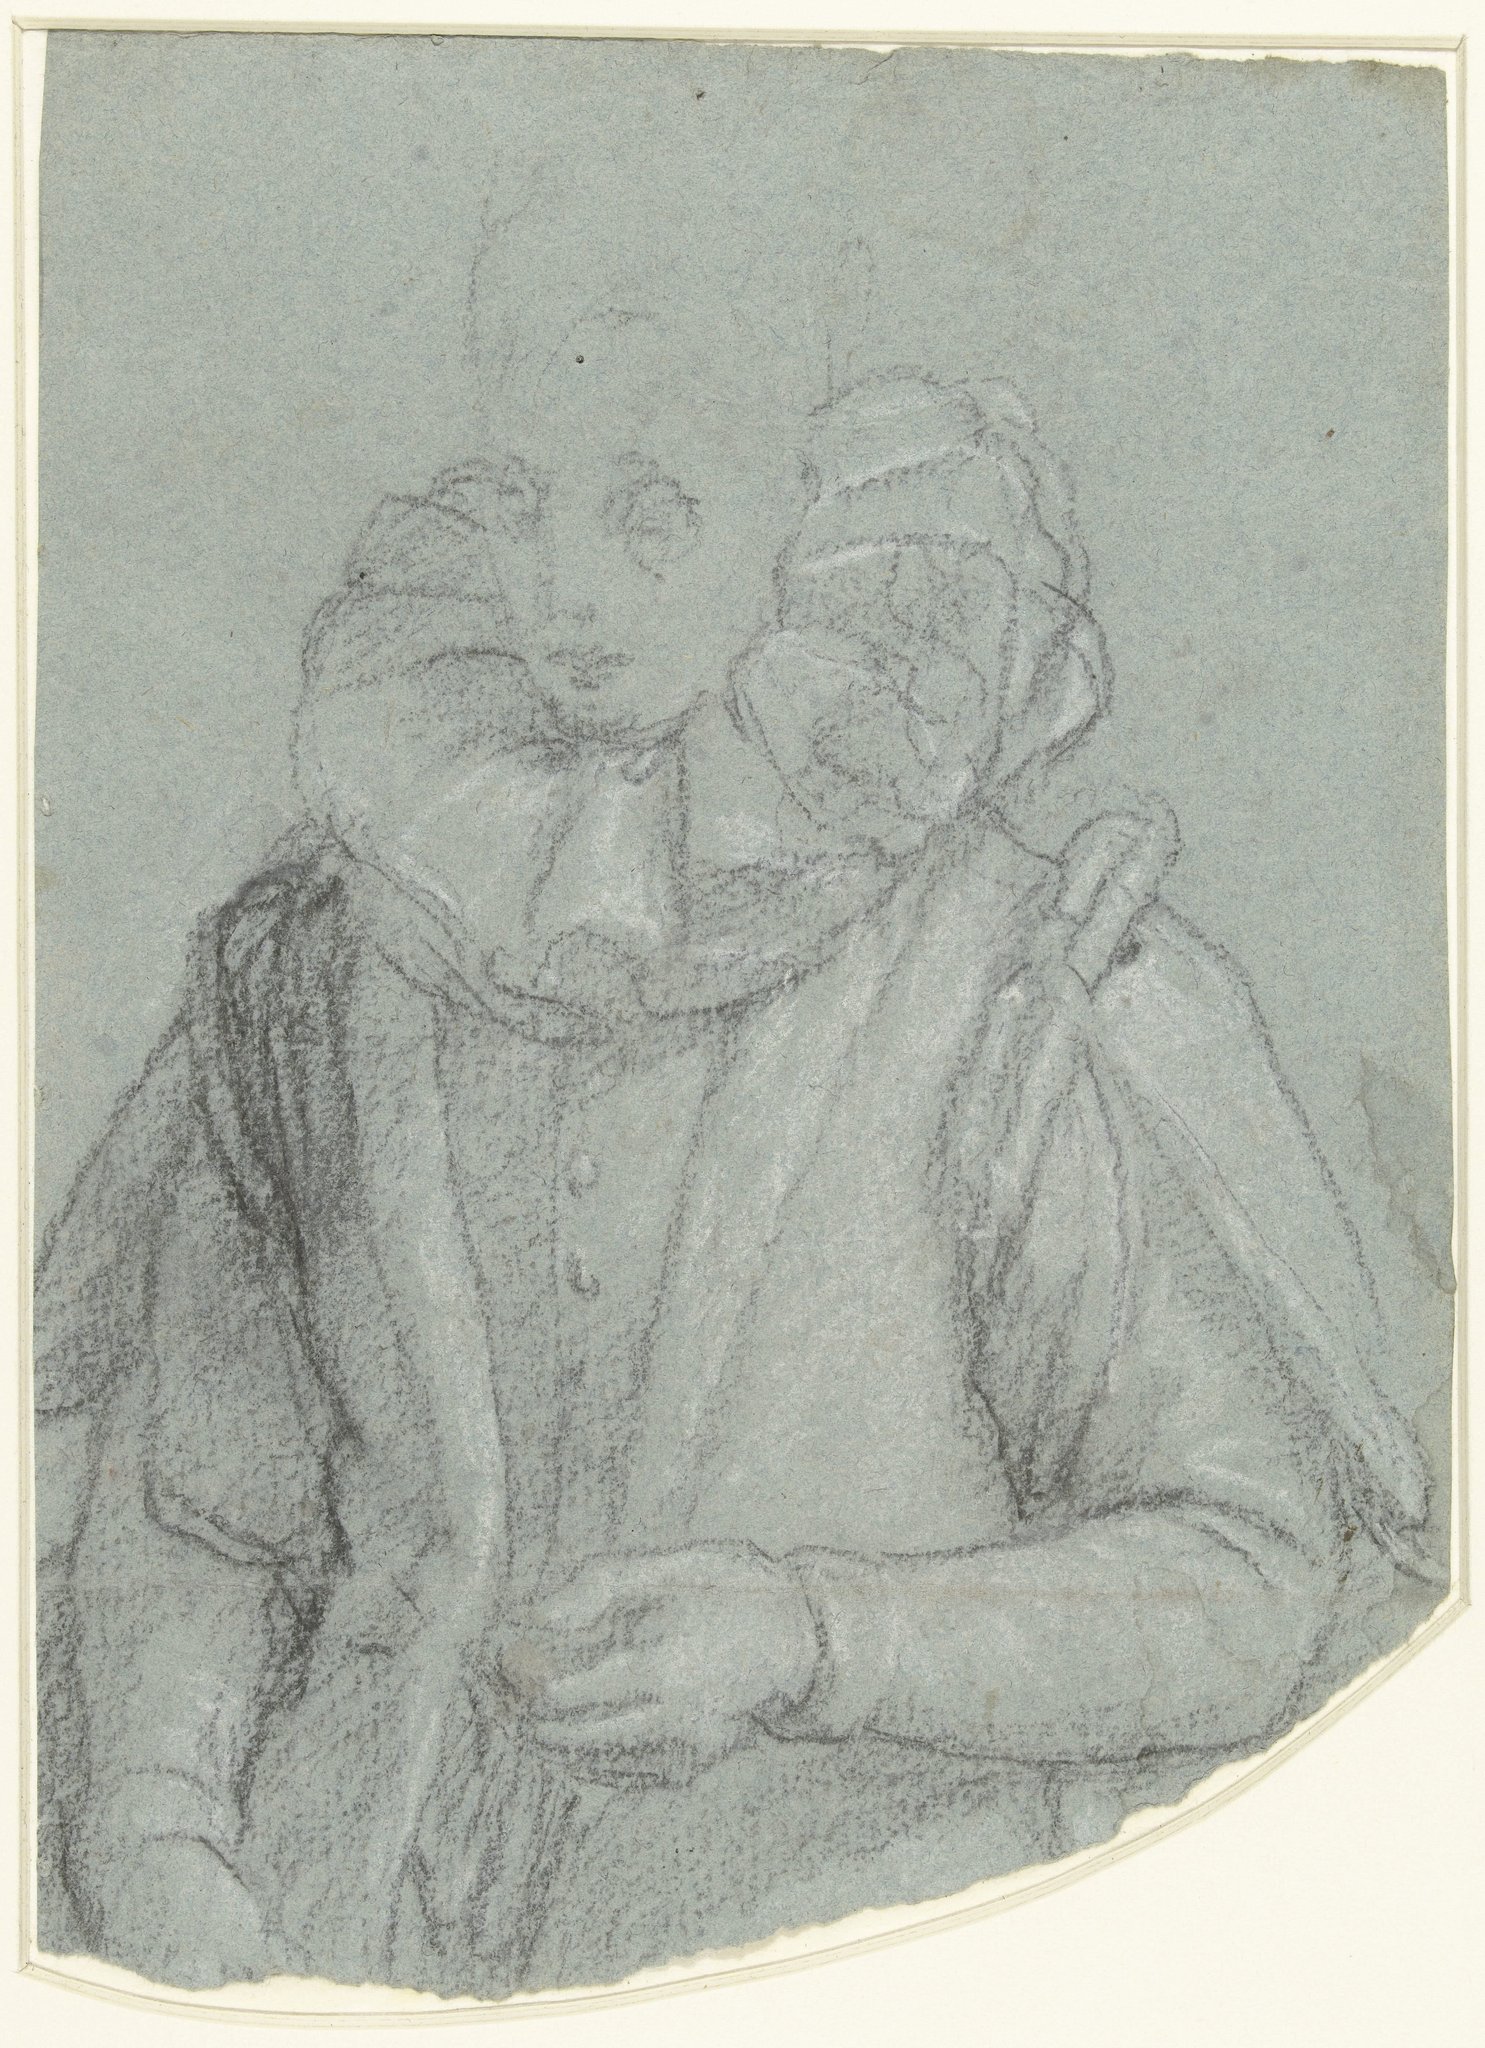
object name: drawing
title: Studie voor een portret van een dame met een brede kraag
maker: Anonymous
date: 1610-1630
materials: chalk, paper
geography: verona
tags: sitting figure - aa - female human figure